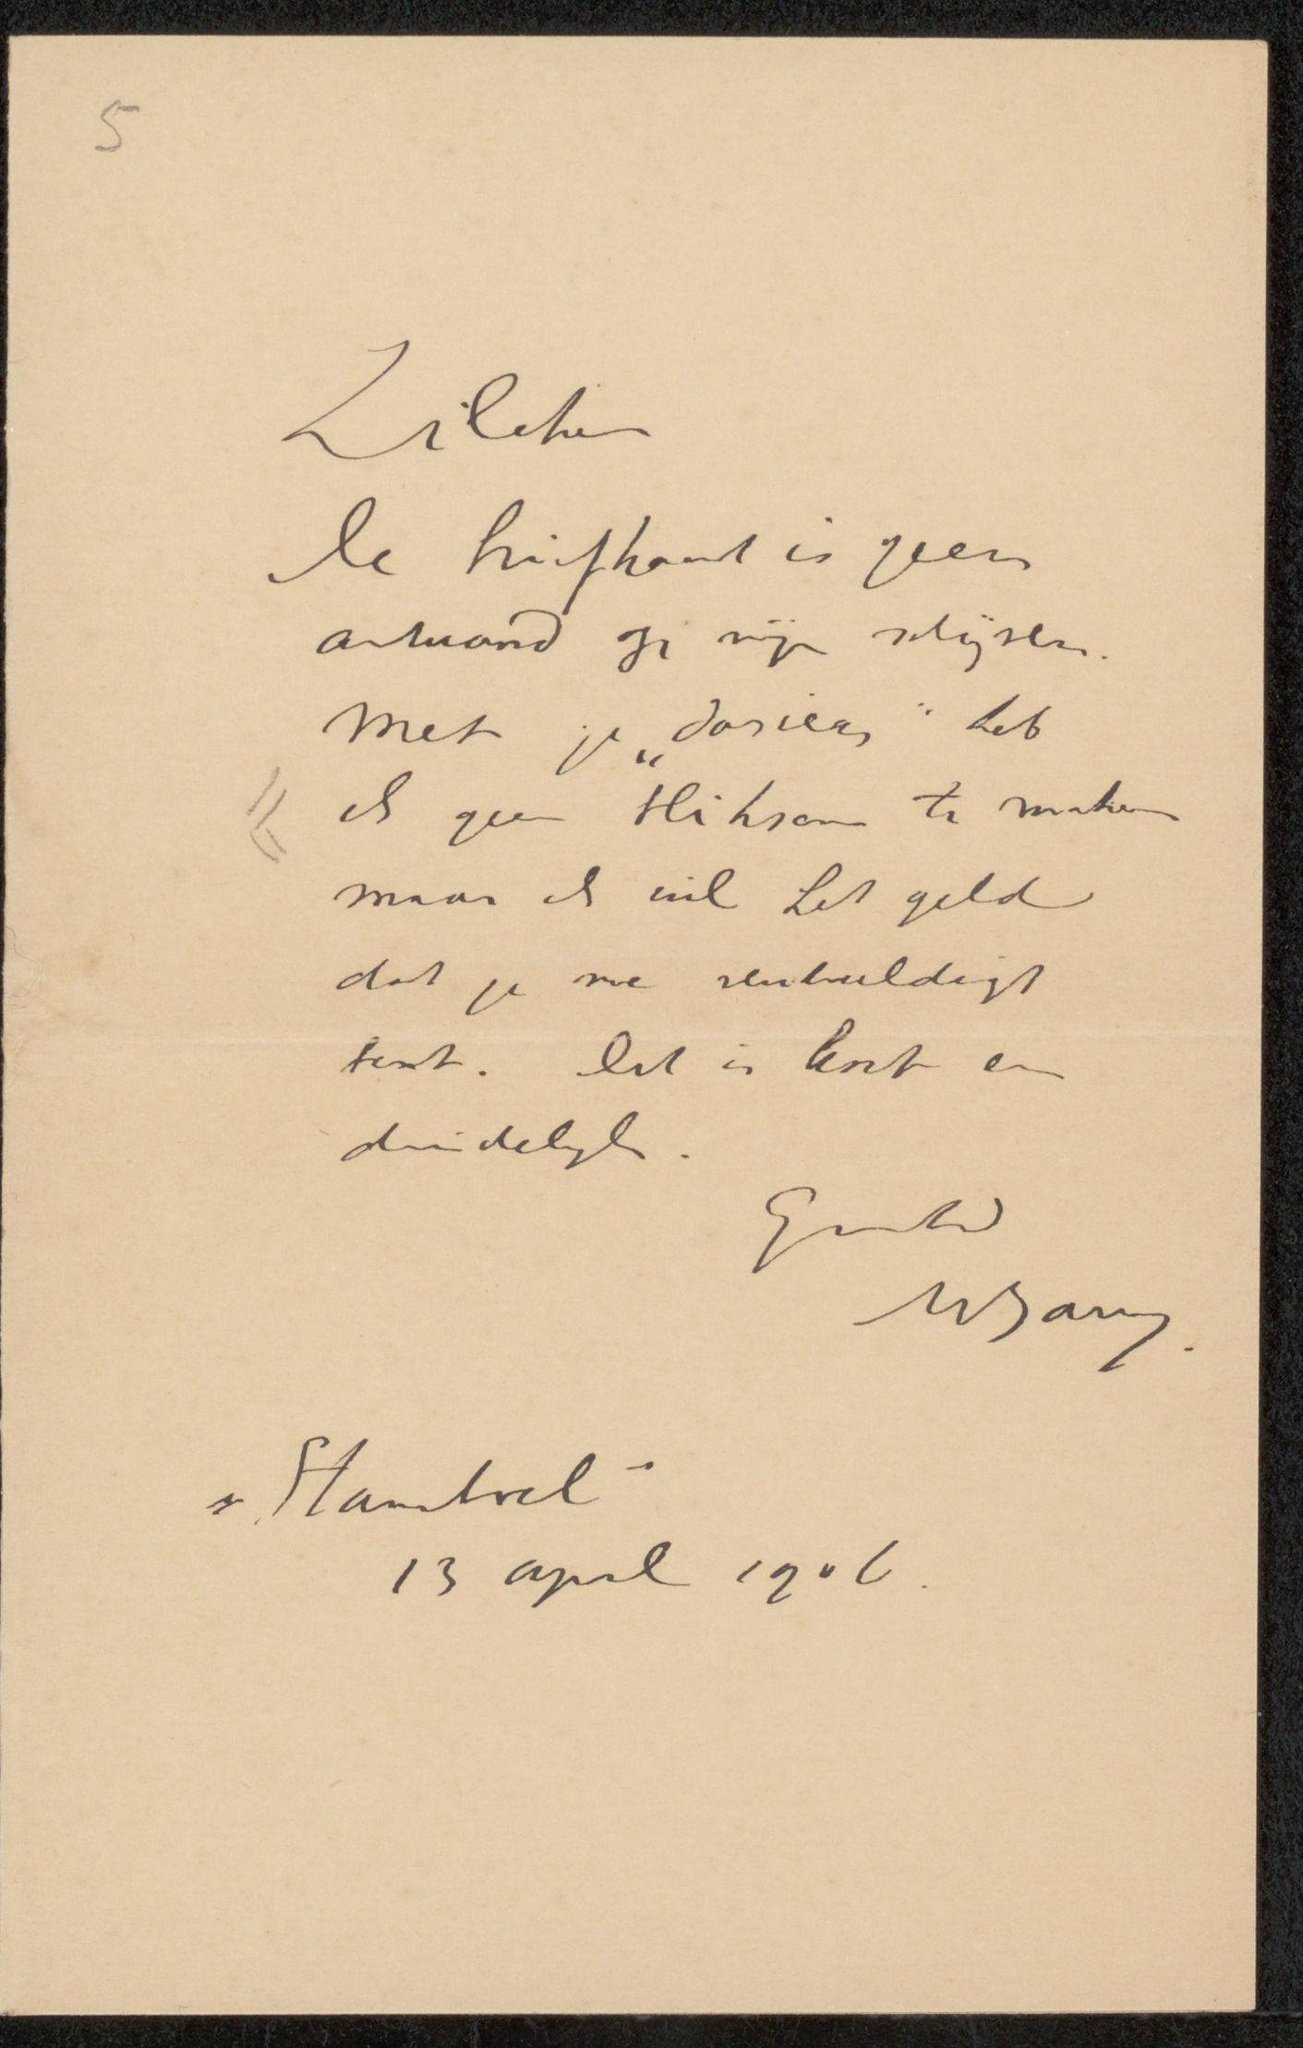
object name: letter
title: Brief aan Philip Zilcken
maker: marius bauer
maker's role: draughtsman, print maker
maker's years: 1867-1932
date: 1906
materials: ink, paper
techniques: pen, writing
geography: aerdenhout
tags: the hague, painter, draughtsman, philip zilcken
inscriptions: collector's mark: ‘RPK’